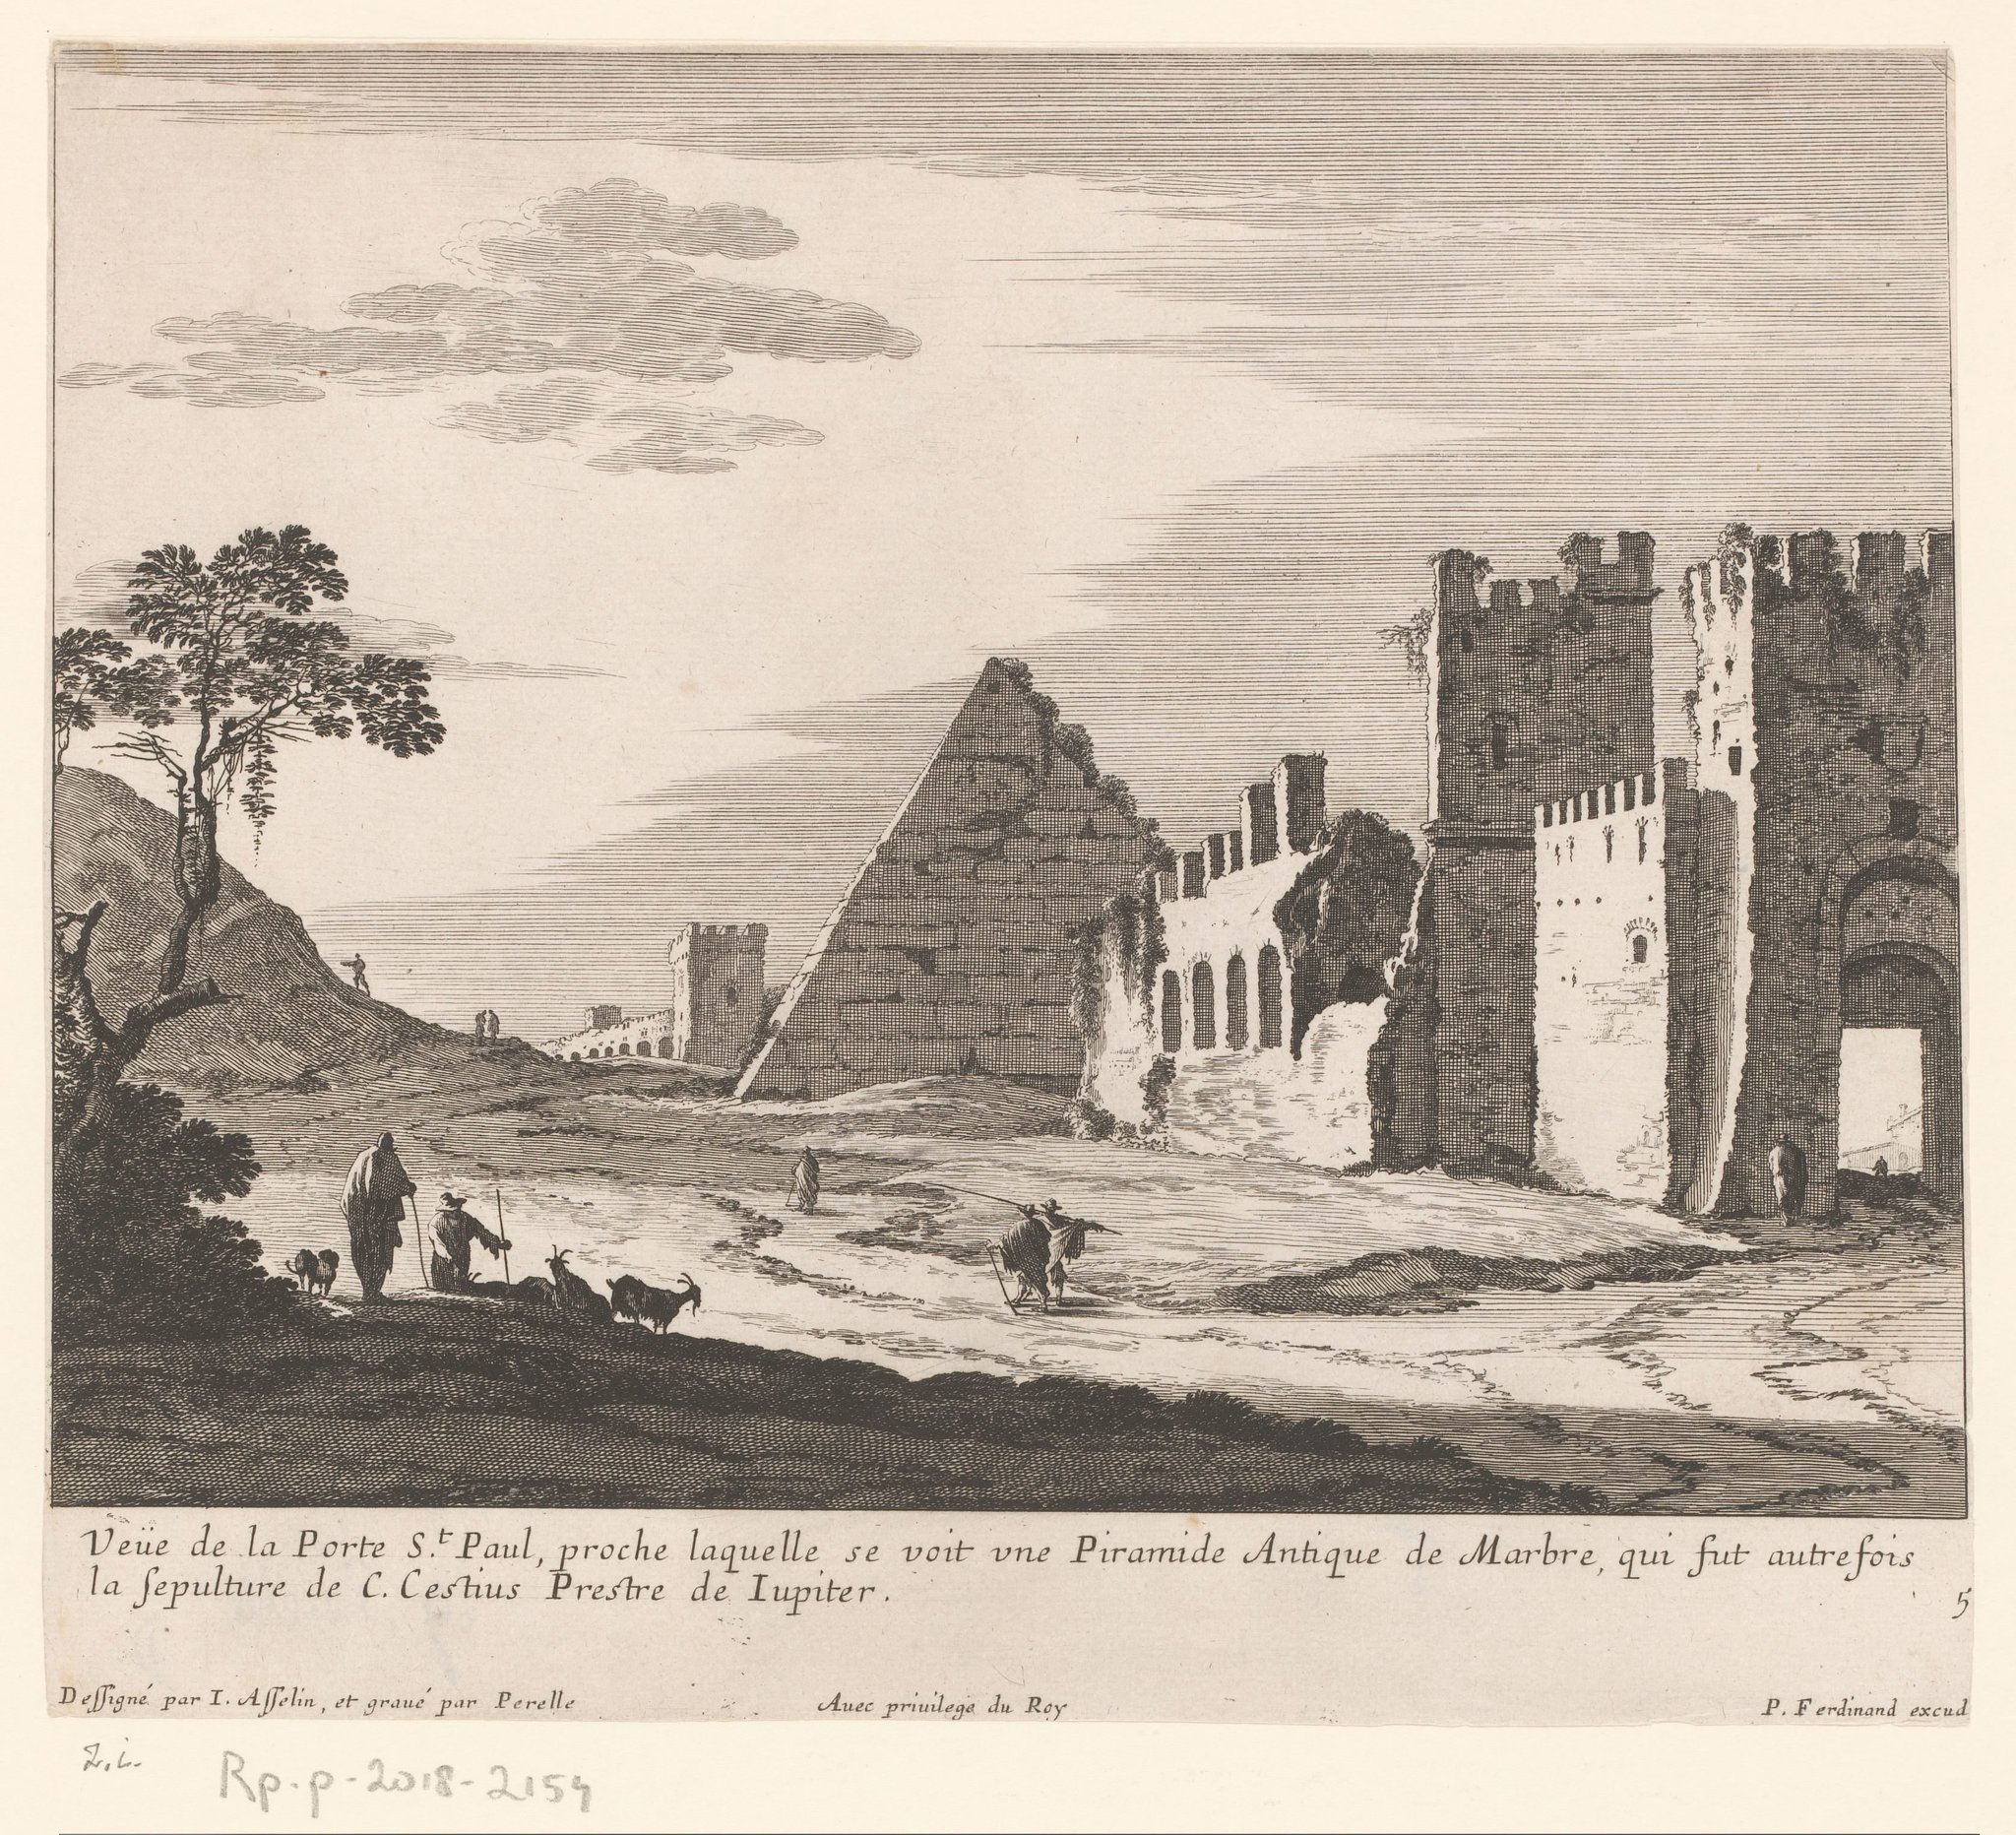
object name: print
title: Gezicht op de Porta San Paolo en de Piramide van Cestius, te Rome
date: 1641-1655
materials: paper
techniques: engraving, etching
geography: paris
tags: pyramid (historical grave form), city-gate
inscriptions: collector's mark: Lugt 240